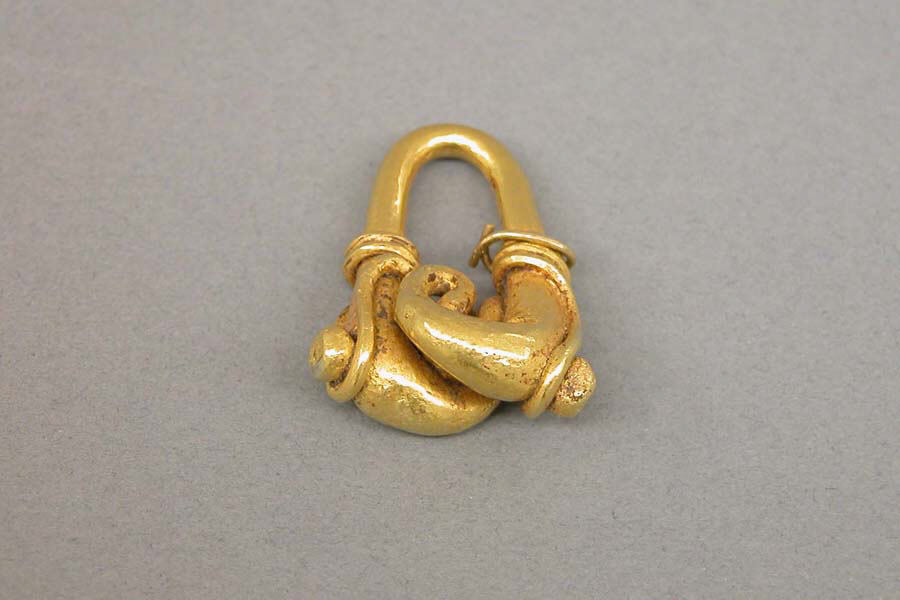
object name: ear ornament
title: Ear Ornament with Twisted Wire Design and Foliate Motif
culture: indonesian, javanese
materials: gold